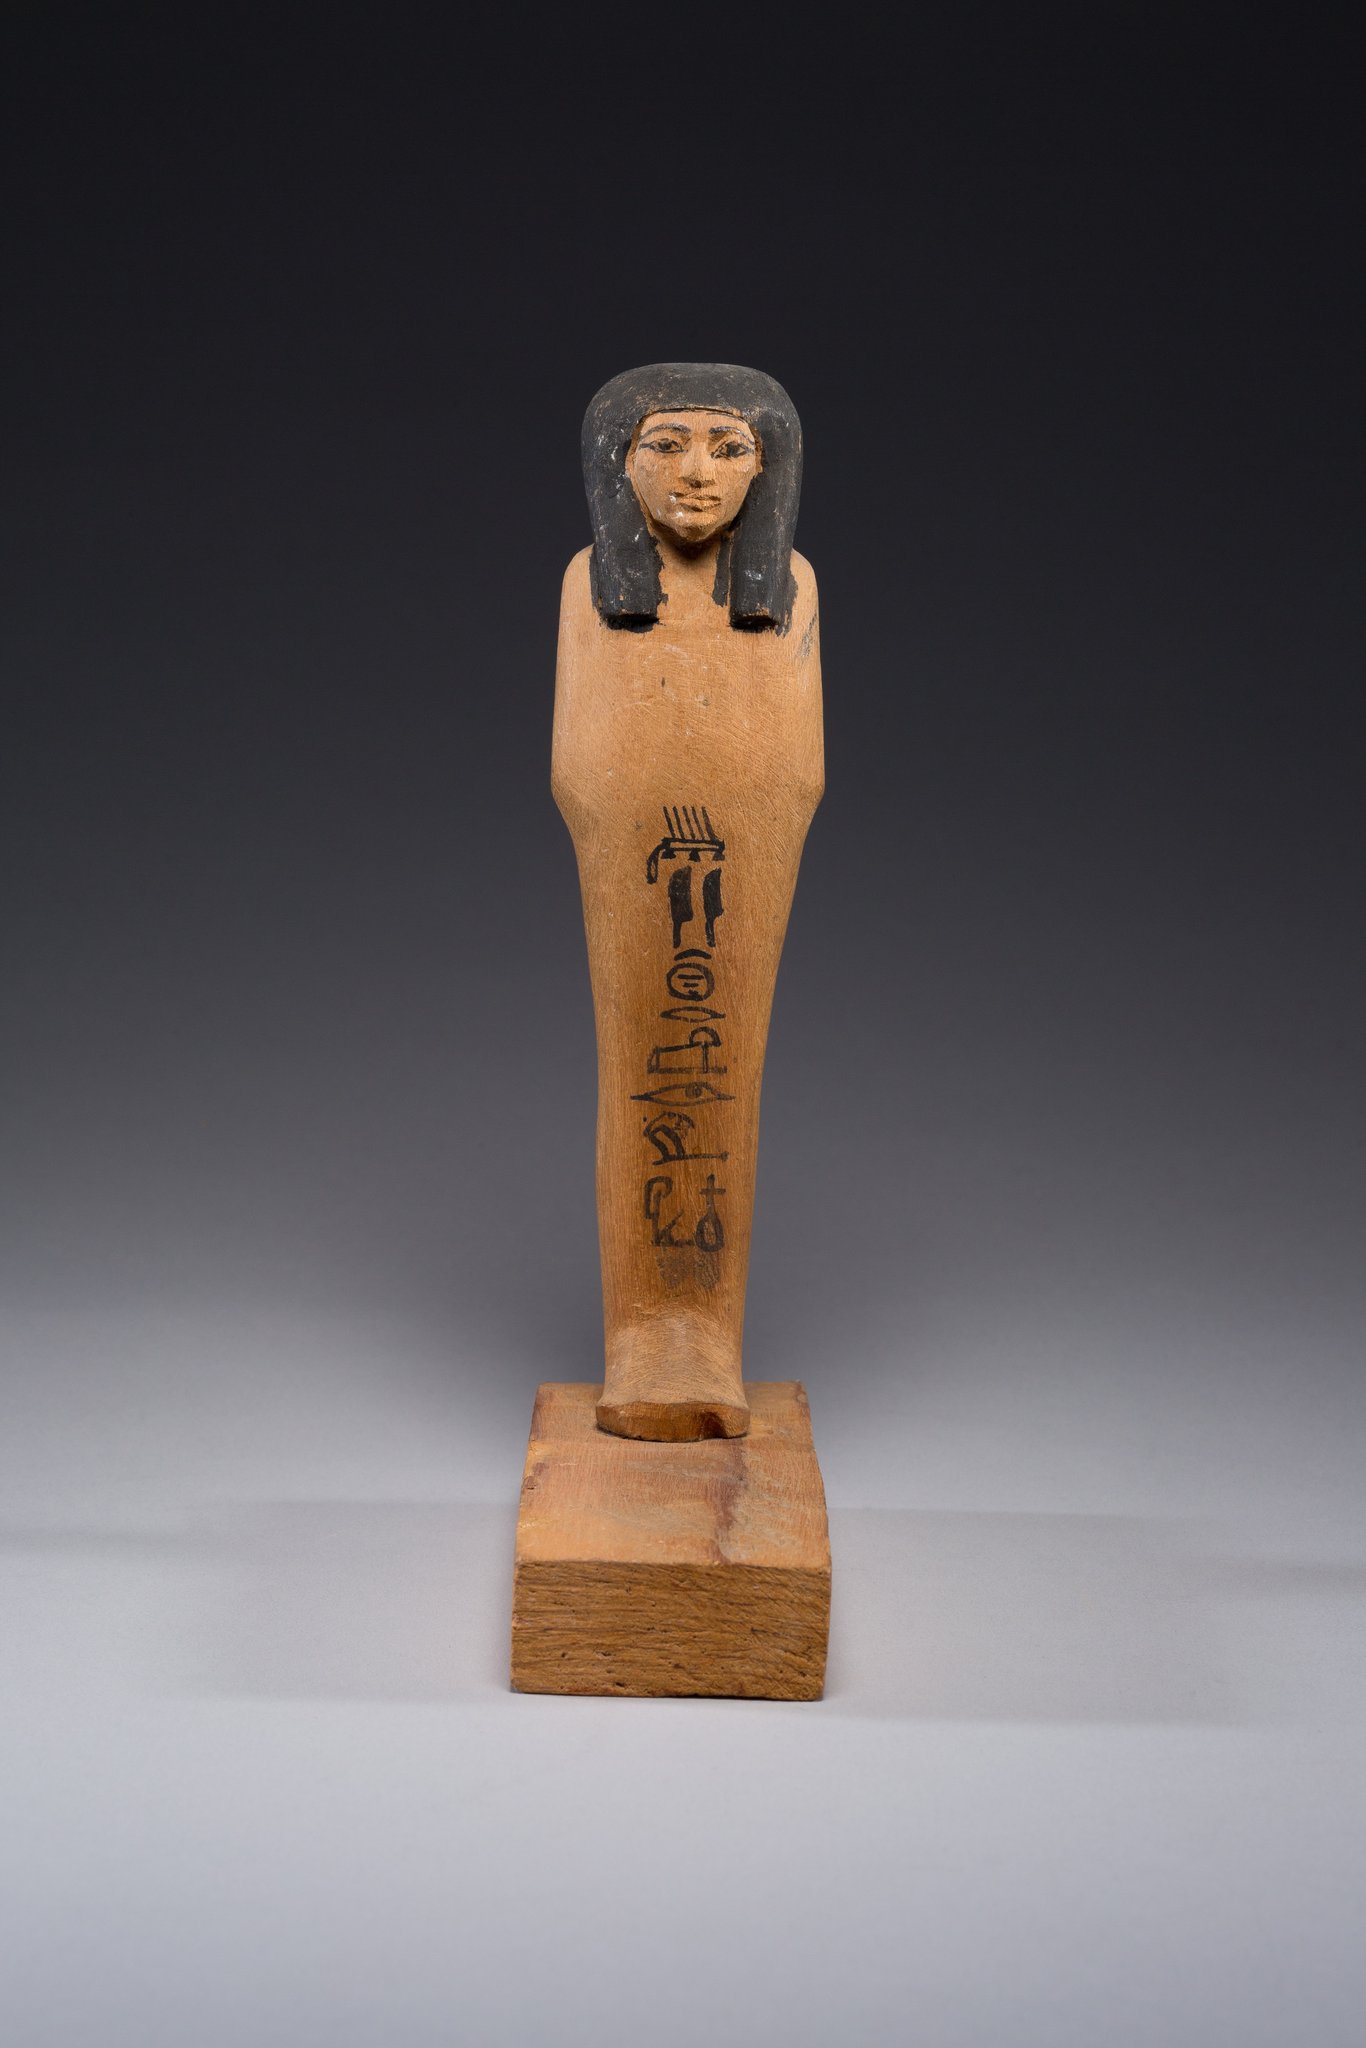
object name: funerary figure, osiride, hatnefer, base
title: Base of Osiris Figure of Hatnefer (see 47.105.2)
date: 1479-1458 BCE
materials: paint, wood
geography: egypt